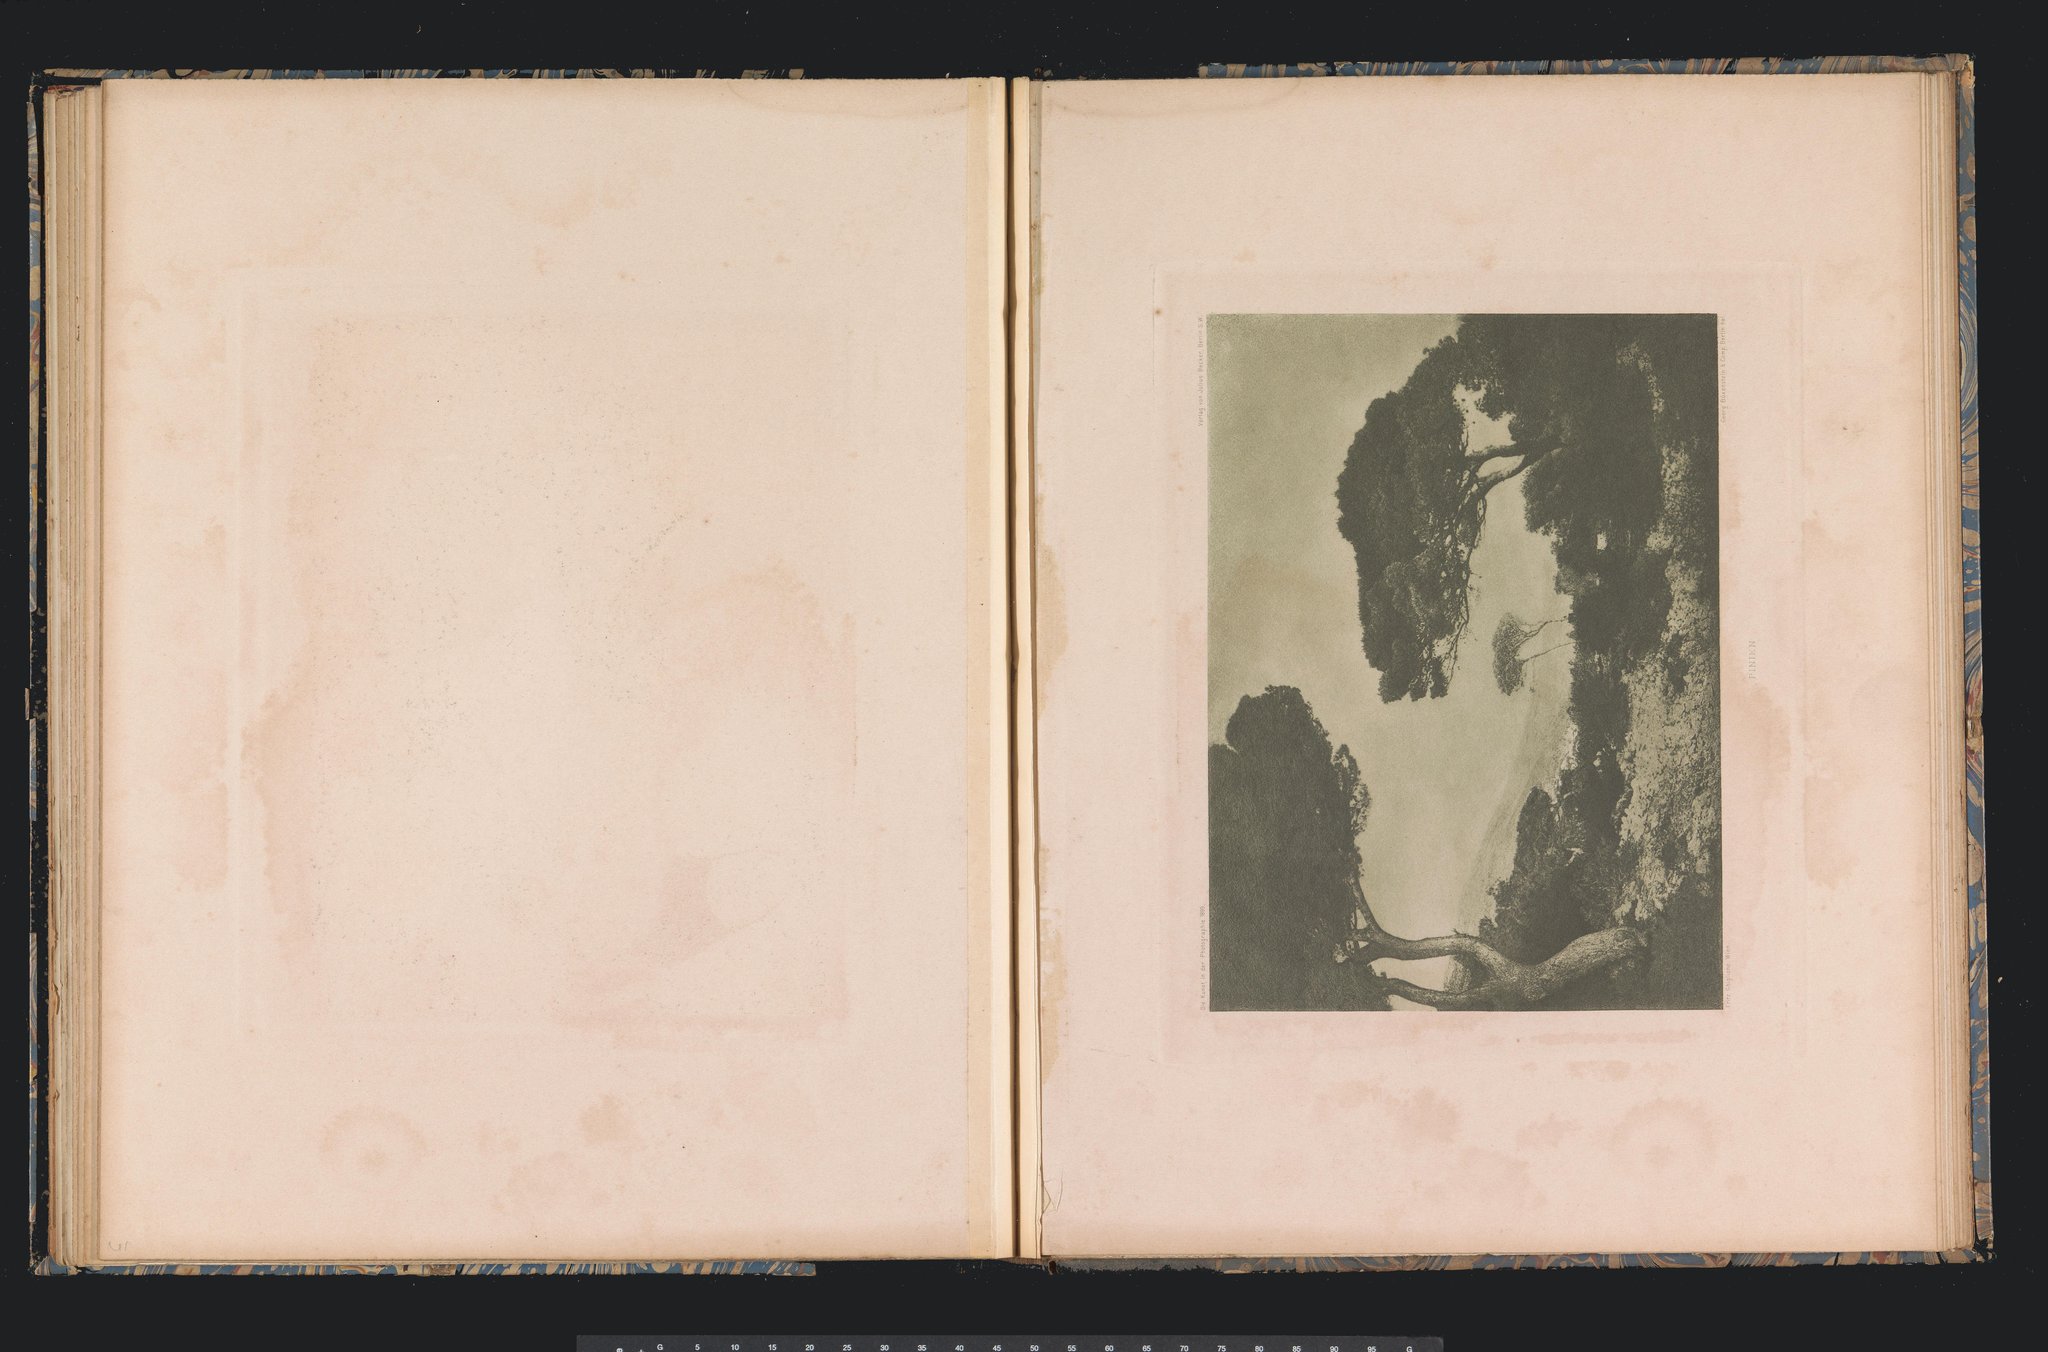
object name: photomechanical print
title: Landschap met pijnbomen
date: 1889-1899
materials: paper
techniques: photoaquatint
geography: hamburg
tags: trees: pine